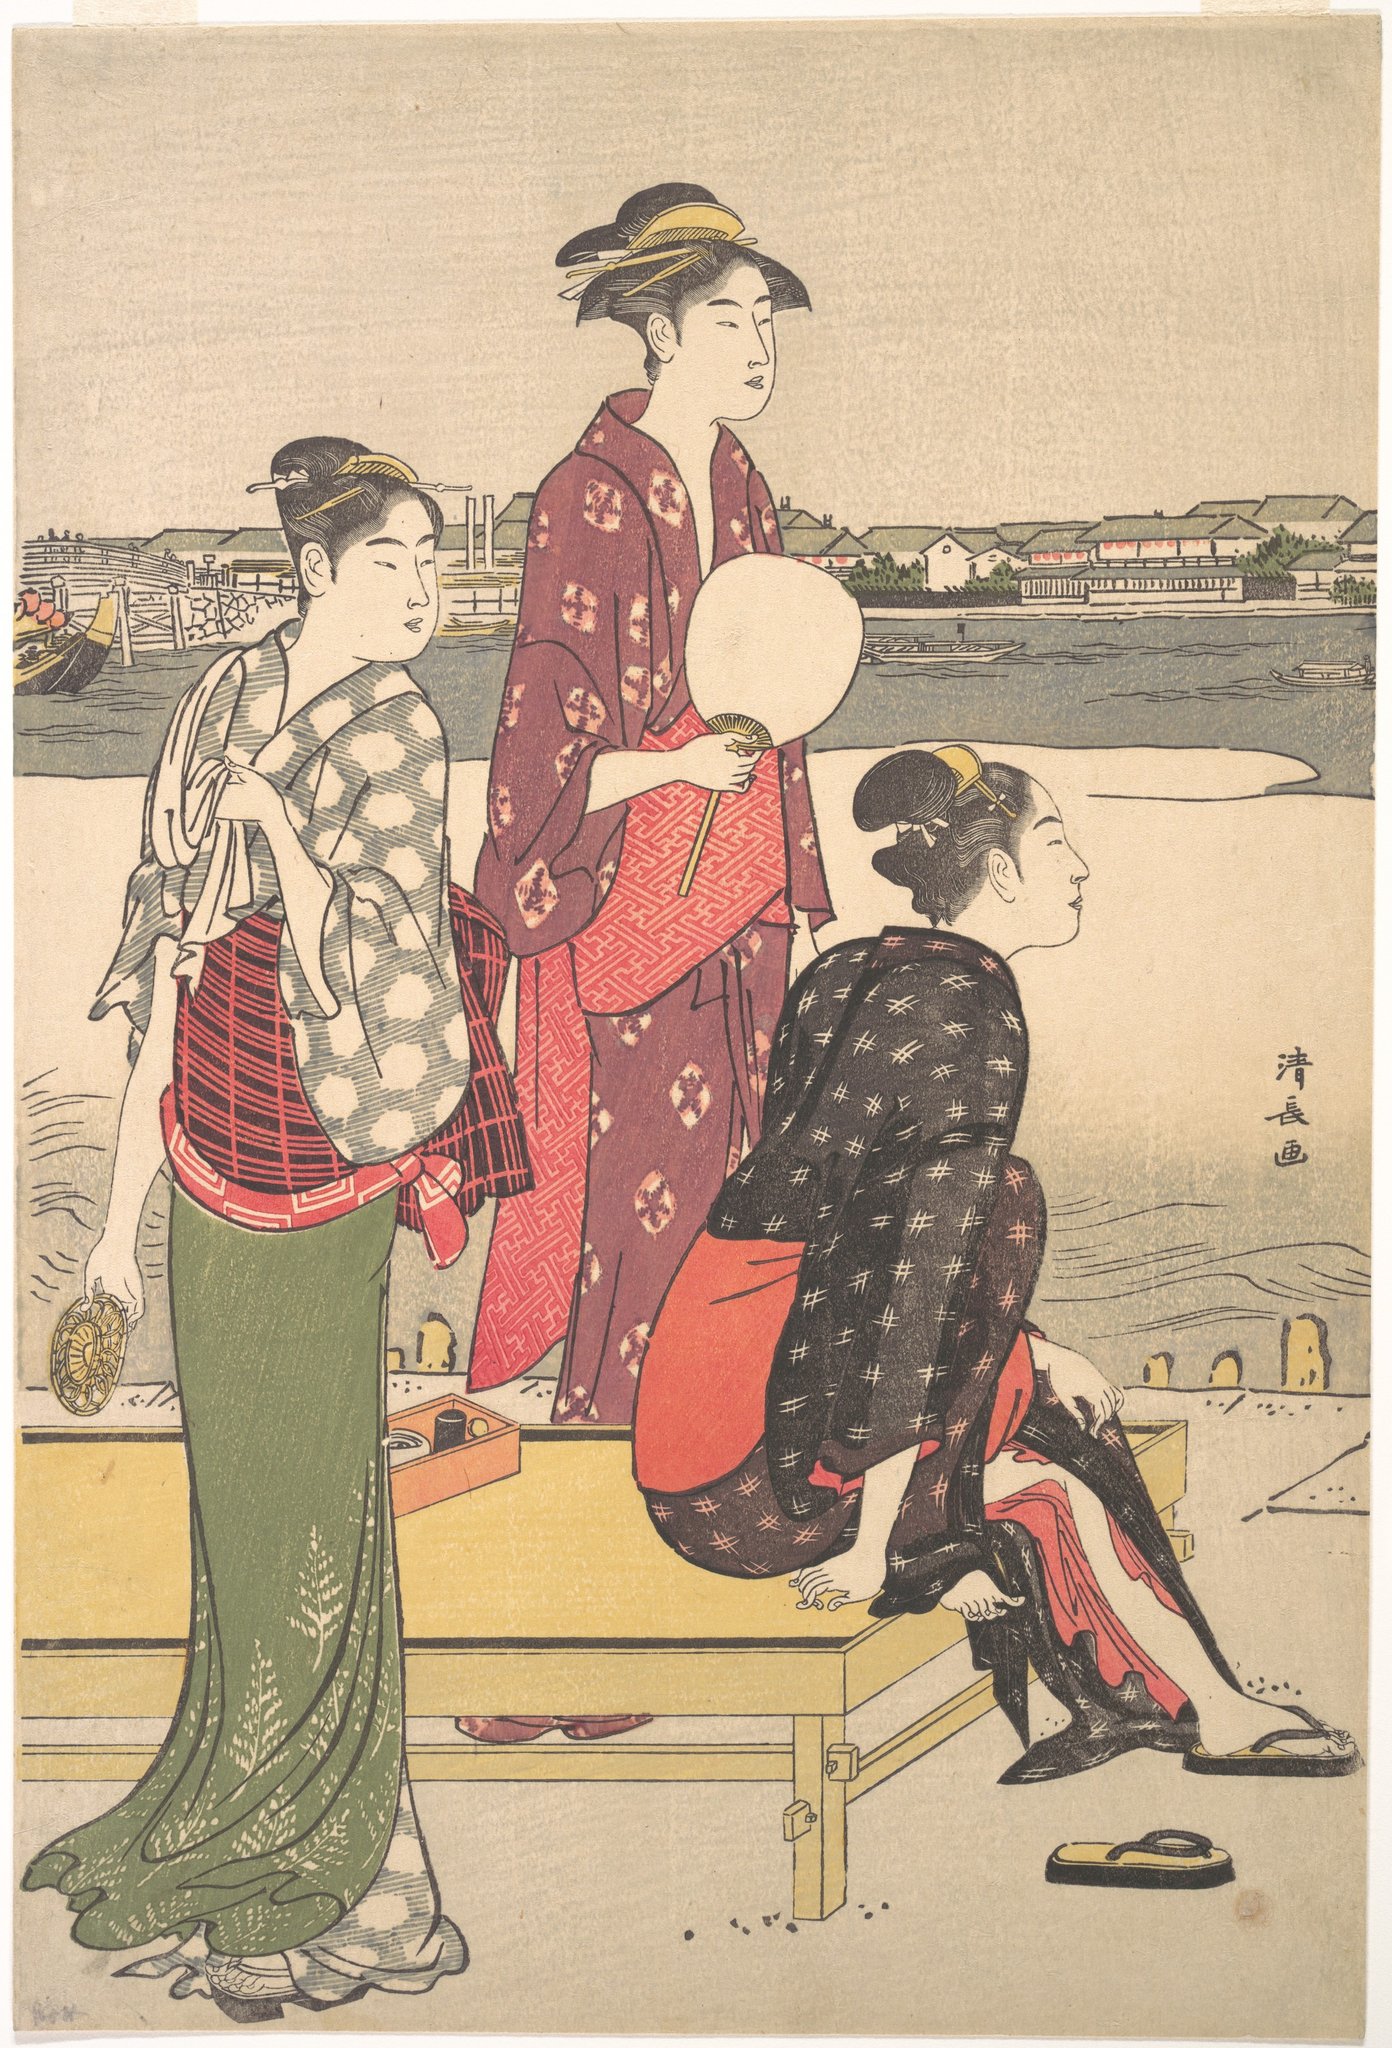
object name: print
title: Evening on the Banks of the Sumida River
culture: japanese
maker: torii kiyonaga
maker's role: artist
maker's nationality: japanese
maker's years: 1752-1815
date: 1742-1815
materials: ink, paper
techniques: woodblock print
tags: houses,women,rivers